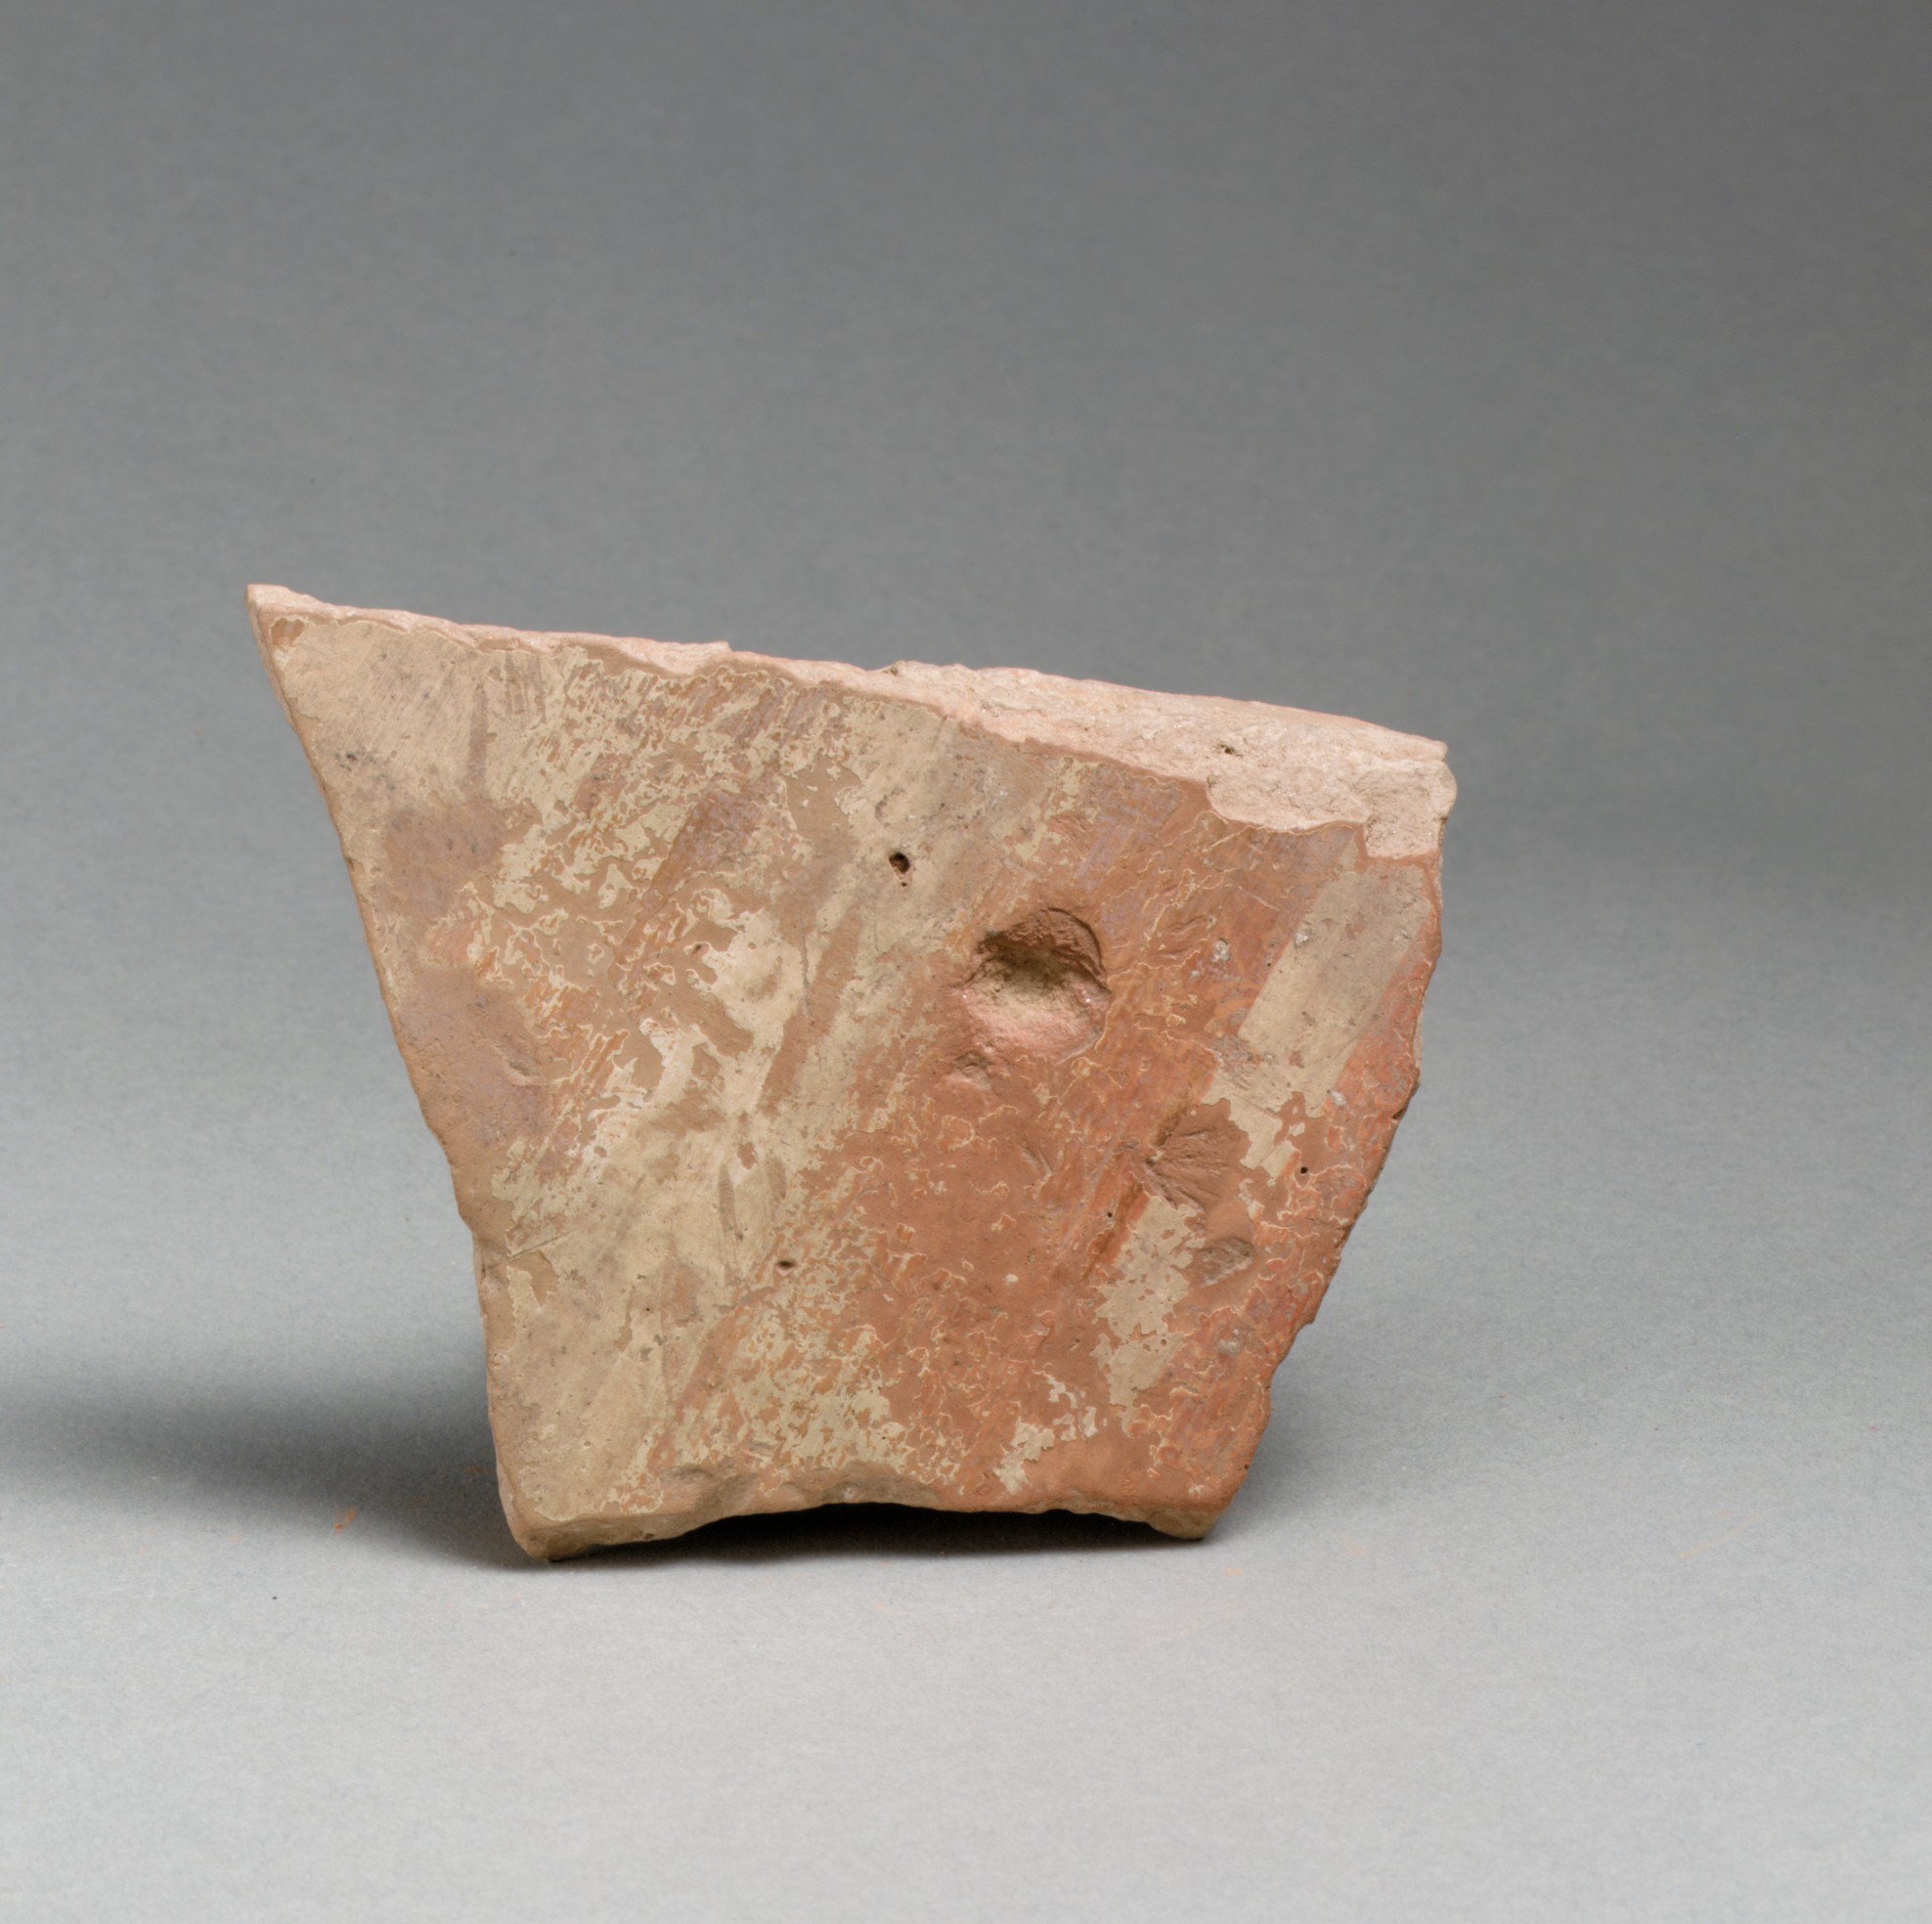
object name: vase fragment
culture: greek or lydian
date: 900-30 BCE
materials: terracotta